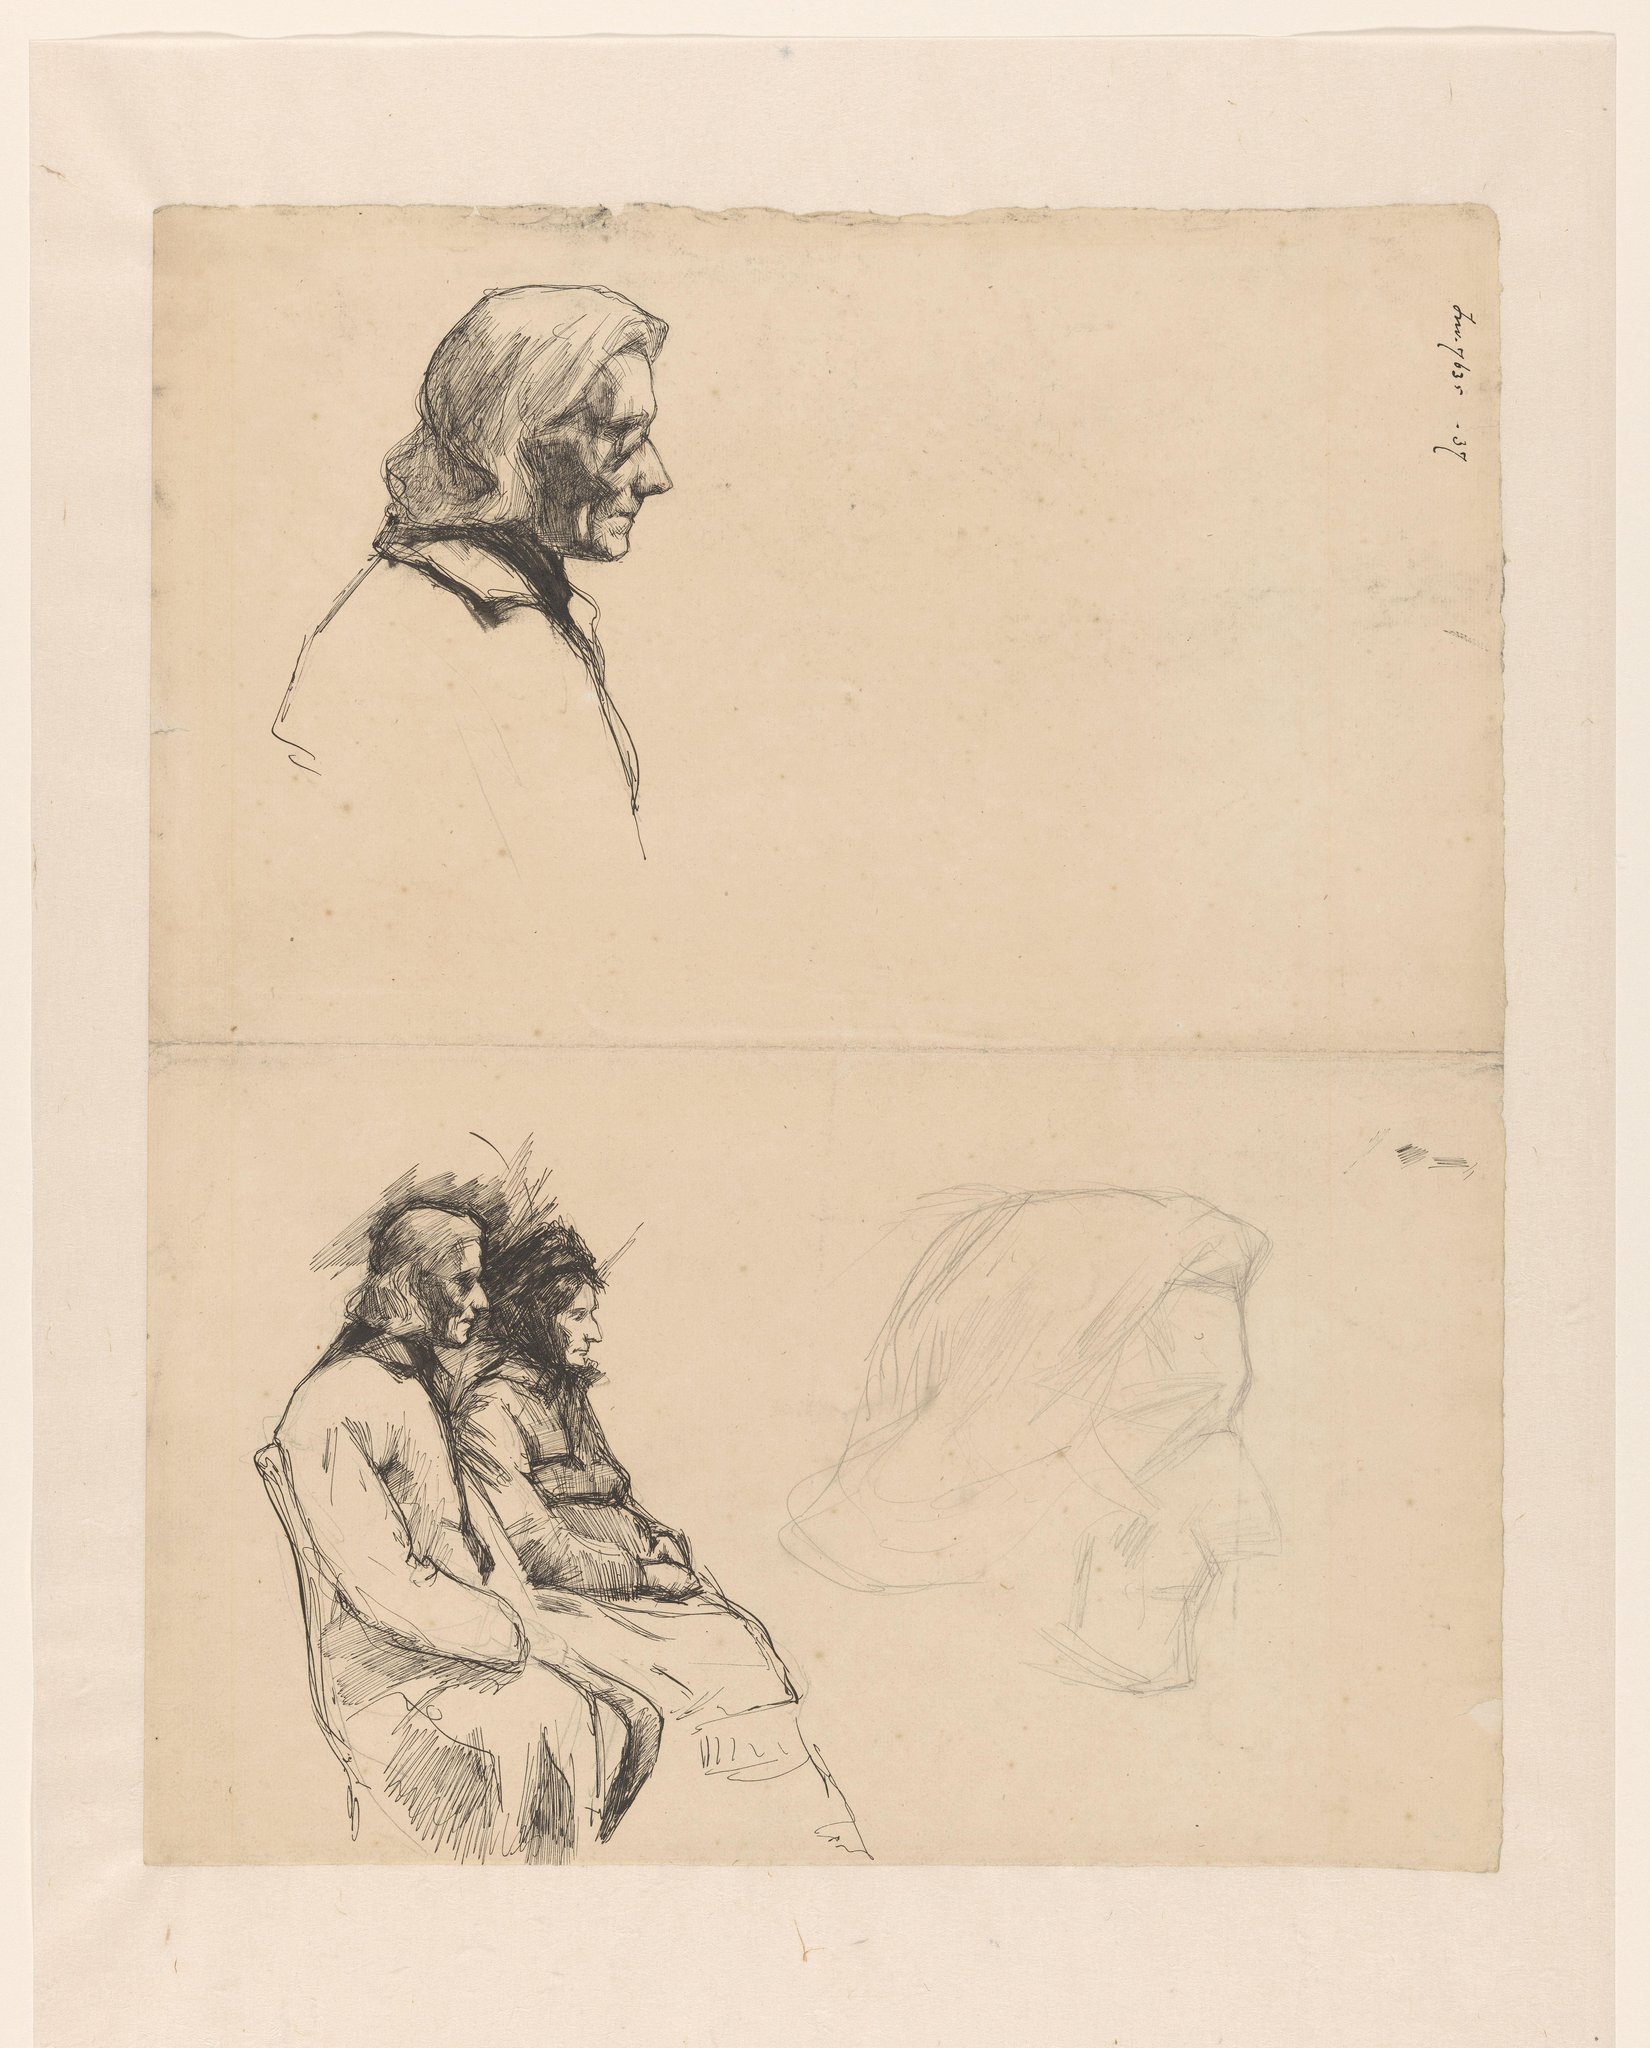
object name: drawing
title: Kop van een blinde man en een zittende man en vrouw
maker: anthon gerhard alexander van rappard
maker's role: draughtsman, print maker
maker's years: 1858-1892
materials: ink, paper, pencil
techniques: brush, pen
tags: blind, blindness, old man, old woman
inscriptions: collector's mark: Lugt 2228